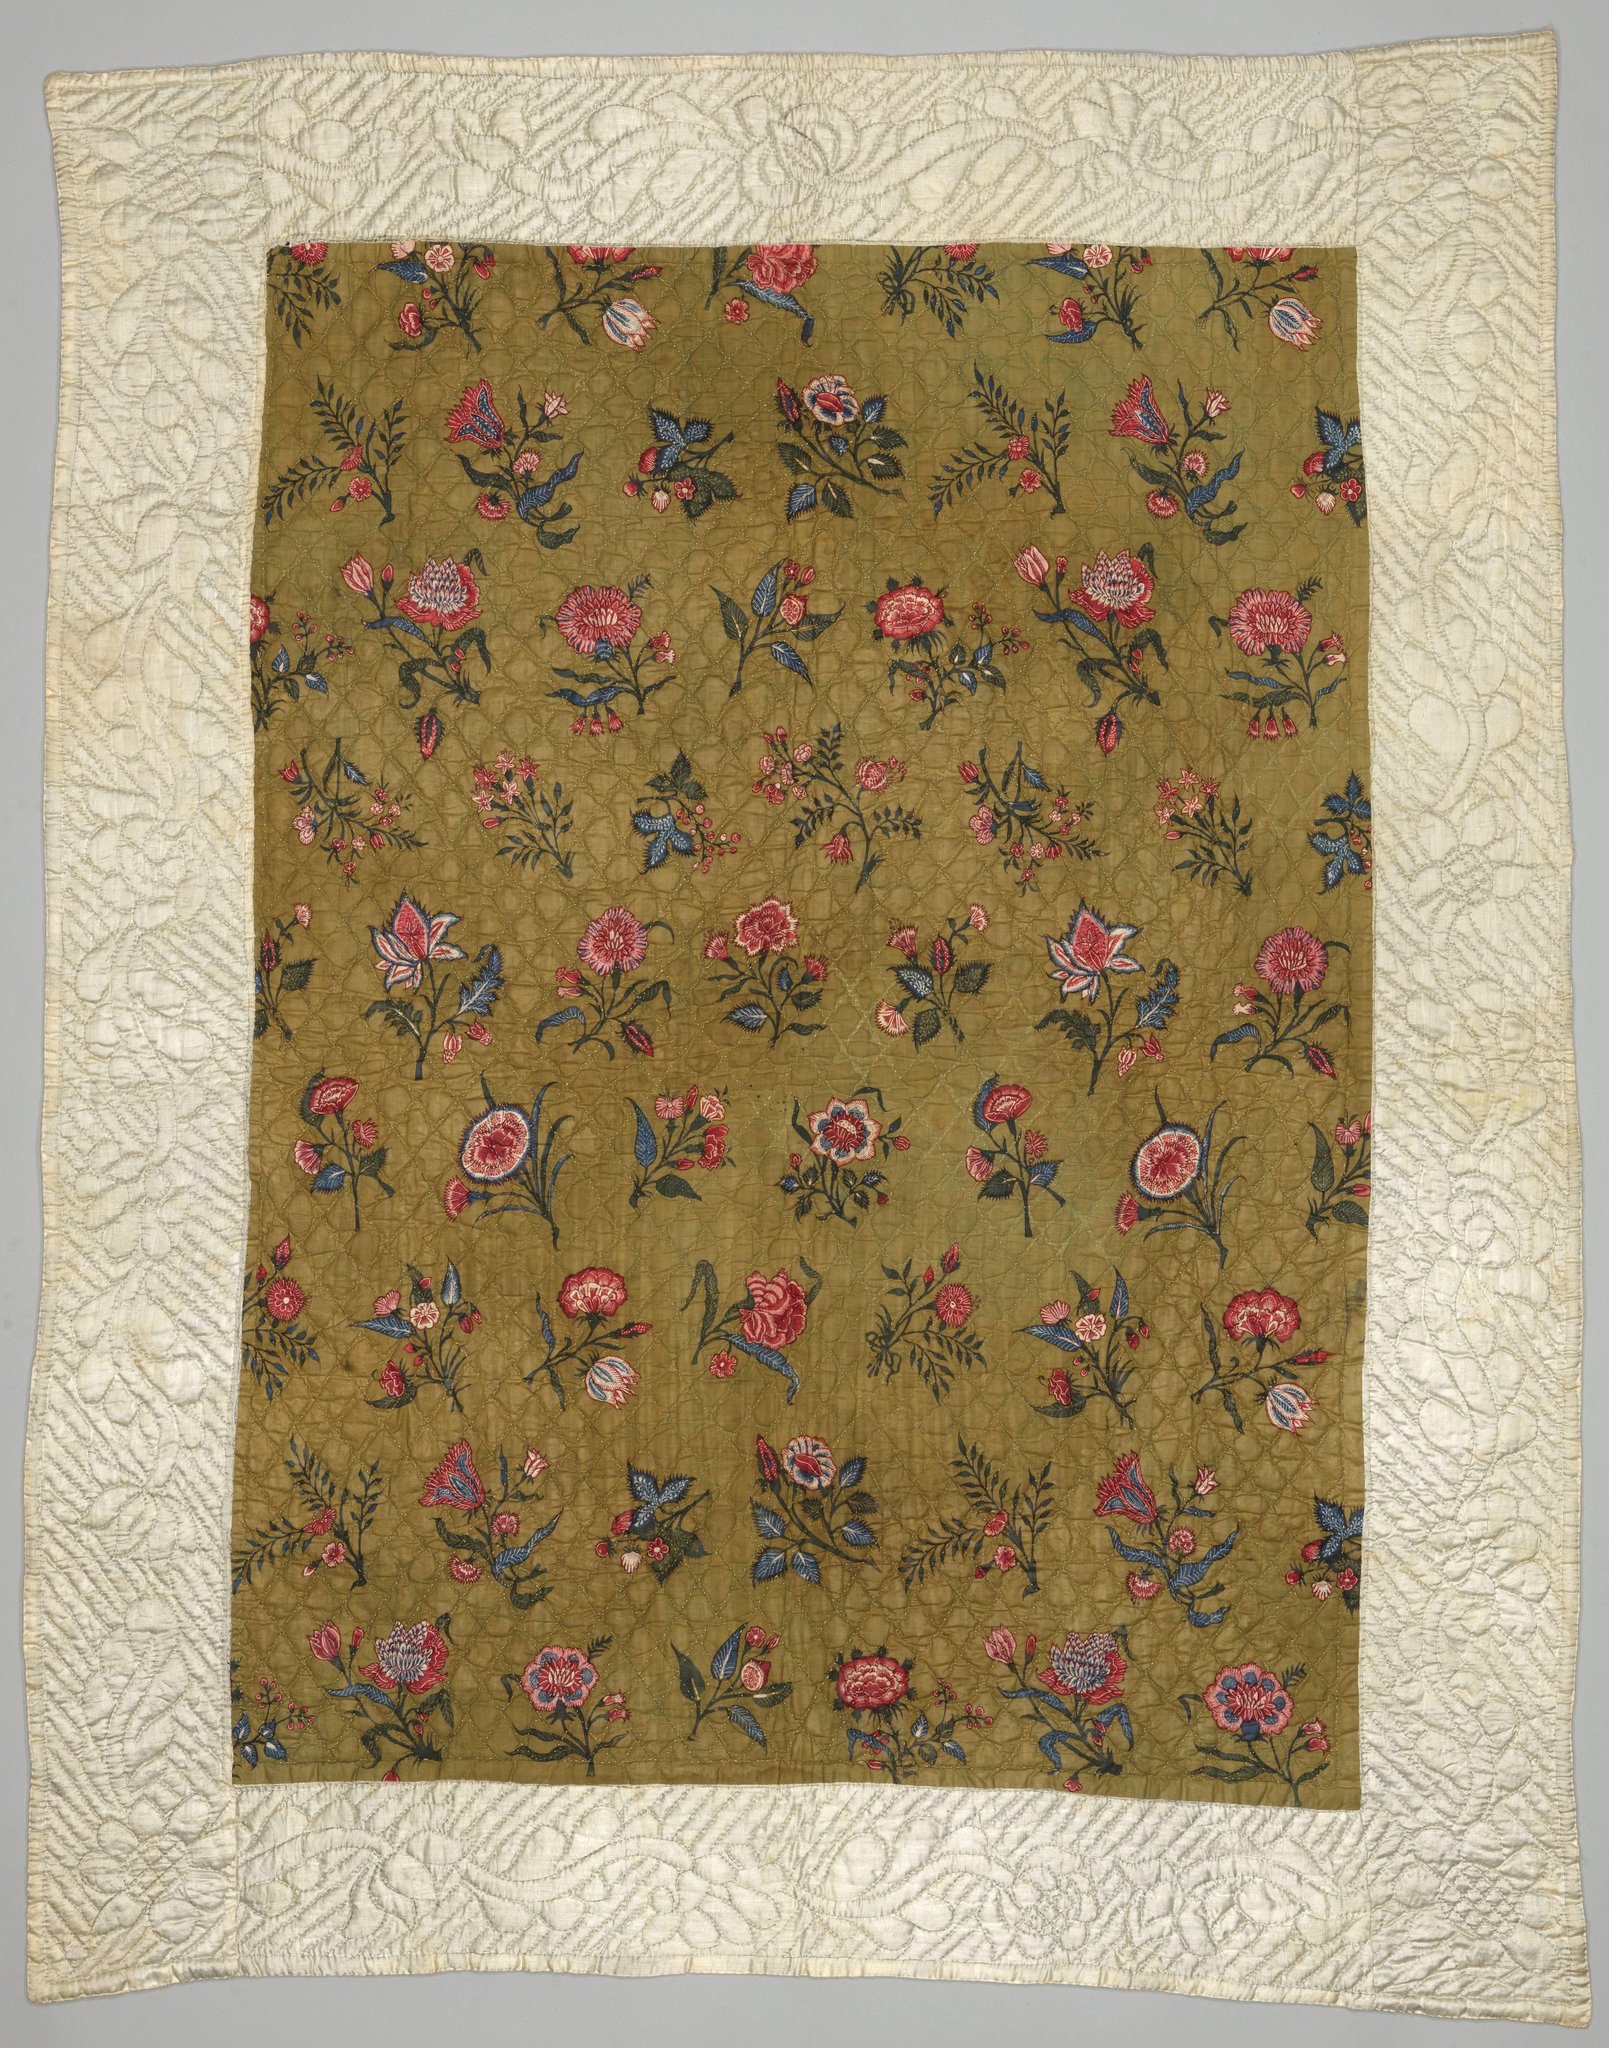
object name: kindersprei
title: Kindersprei van sits met gestrooid bloemenpatroon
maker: Anonymous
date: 1740-1750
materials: textile, cotton, silk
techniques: padding, painted, quilting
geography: india